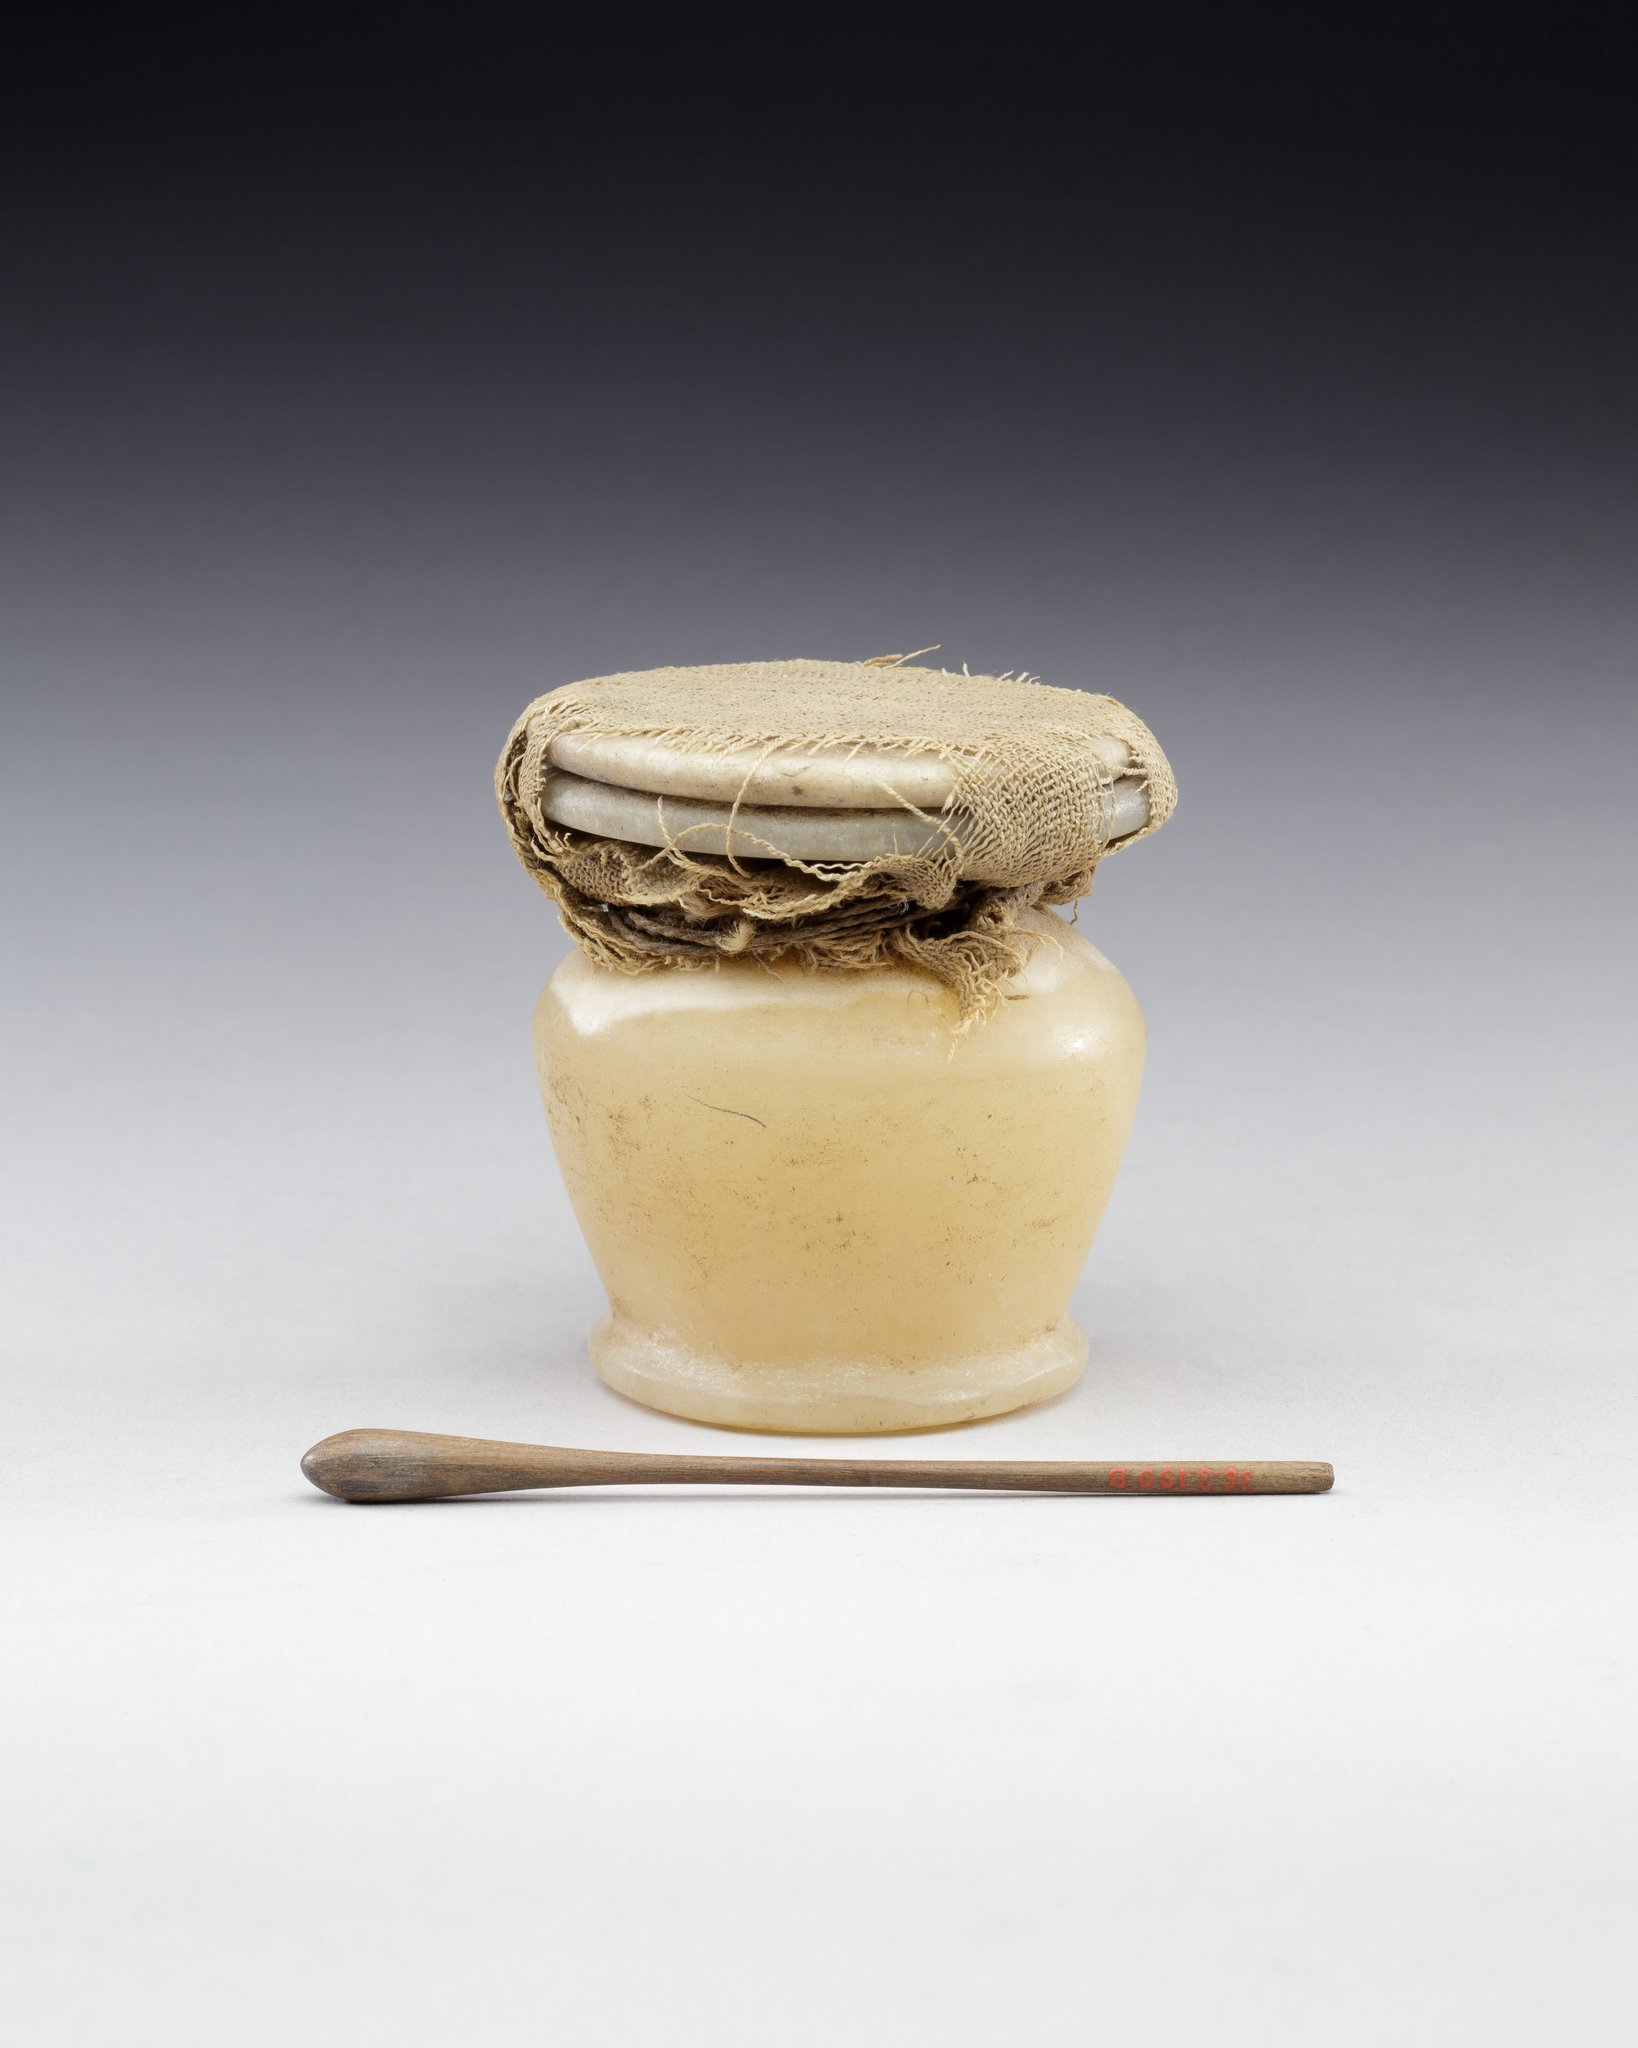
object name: kohl jar, stick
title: Kohl Jar with the Lid Tied in Place and Kohl Stick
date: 1492-1473 BCE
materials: cord, wood, linen, stone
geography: egypt